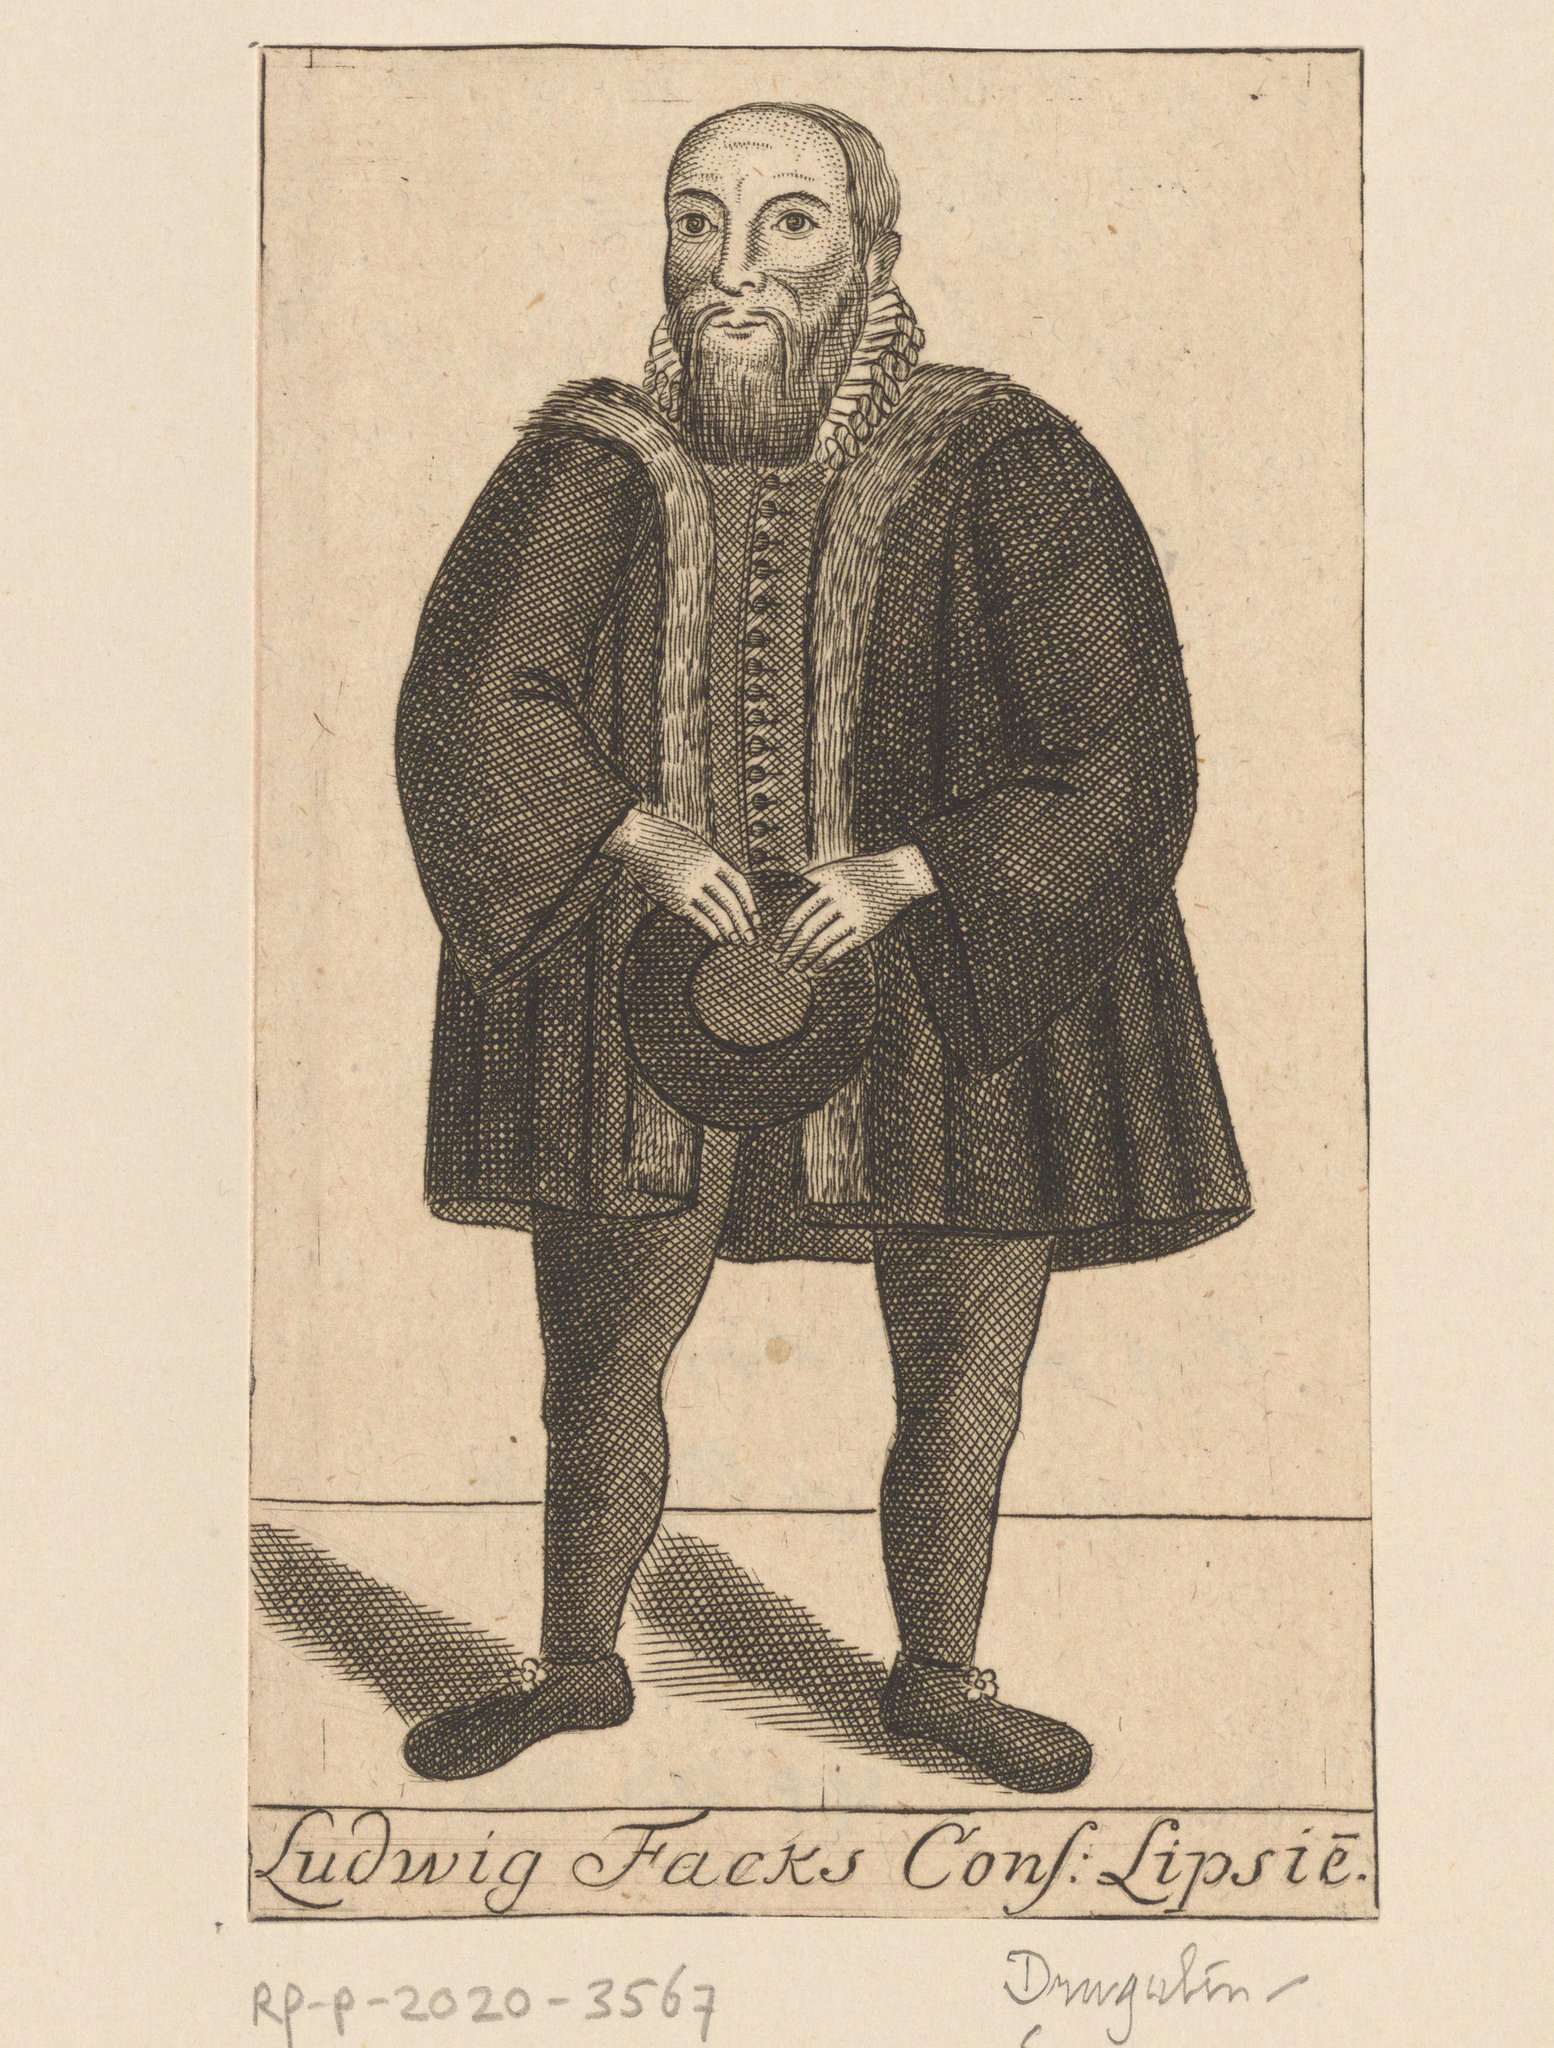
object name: print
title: Portret van Ludwig Fachs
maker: Anonymous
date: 1550-1600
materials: paper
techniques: engraving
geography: germany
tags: mayor, mayor, burgomaster, historical persons